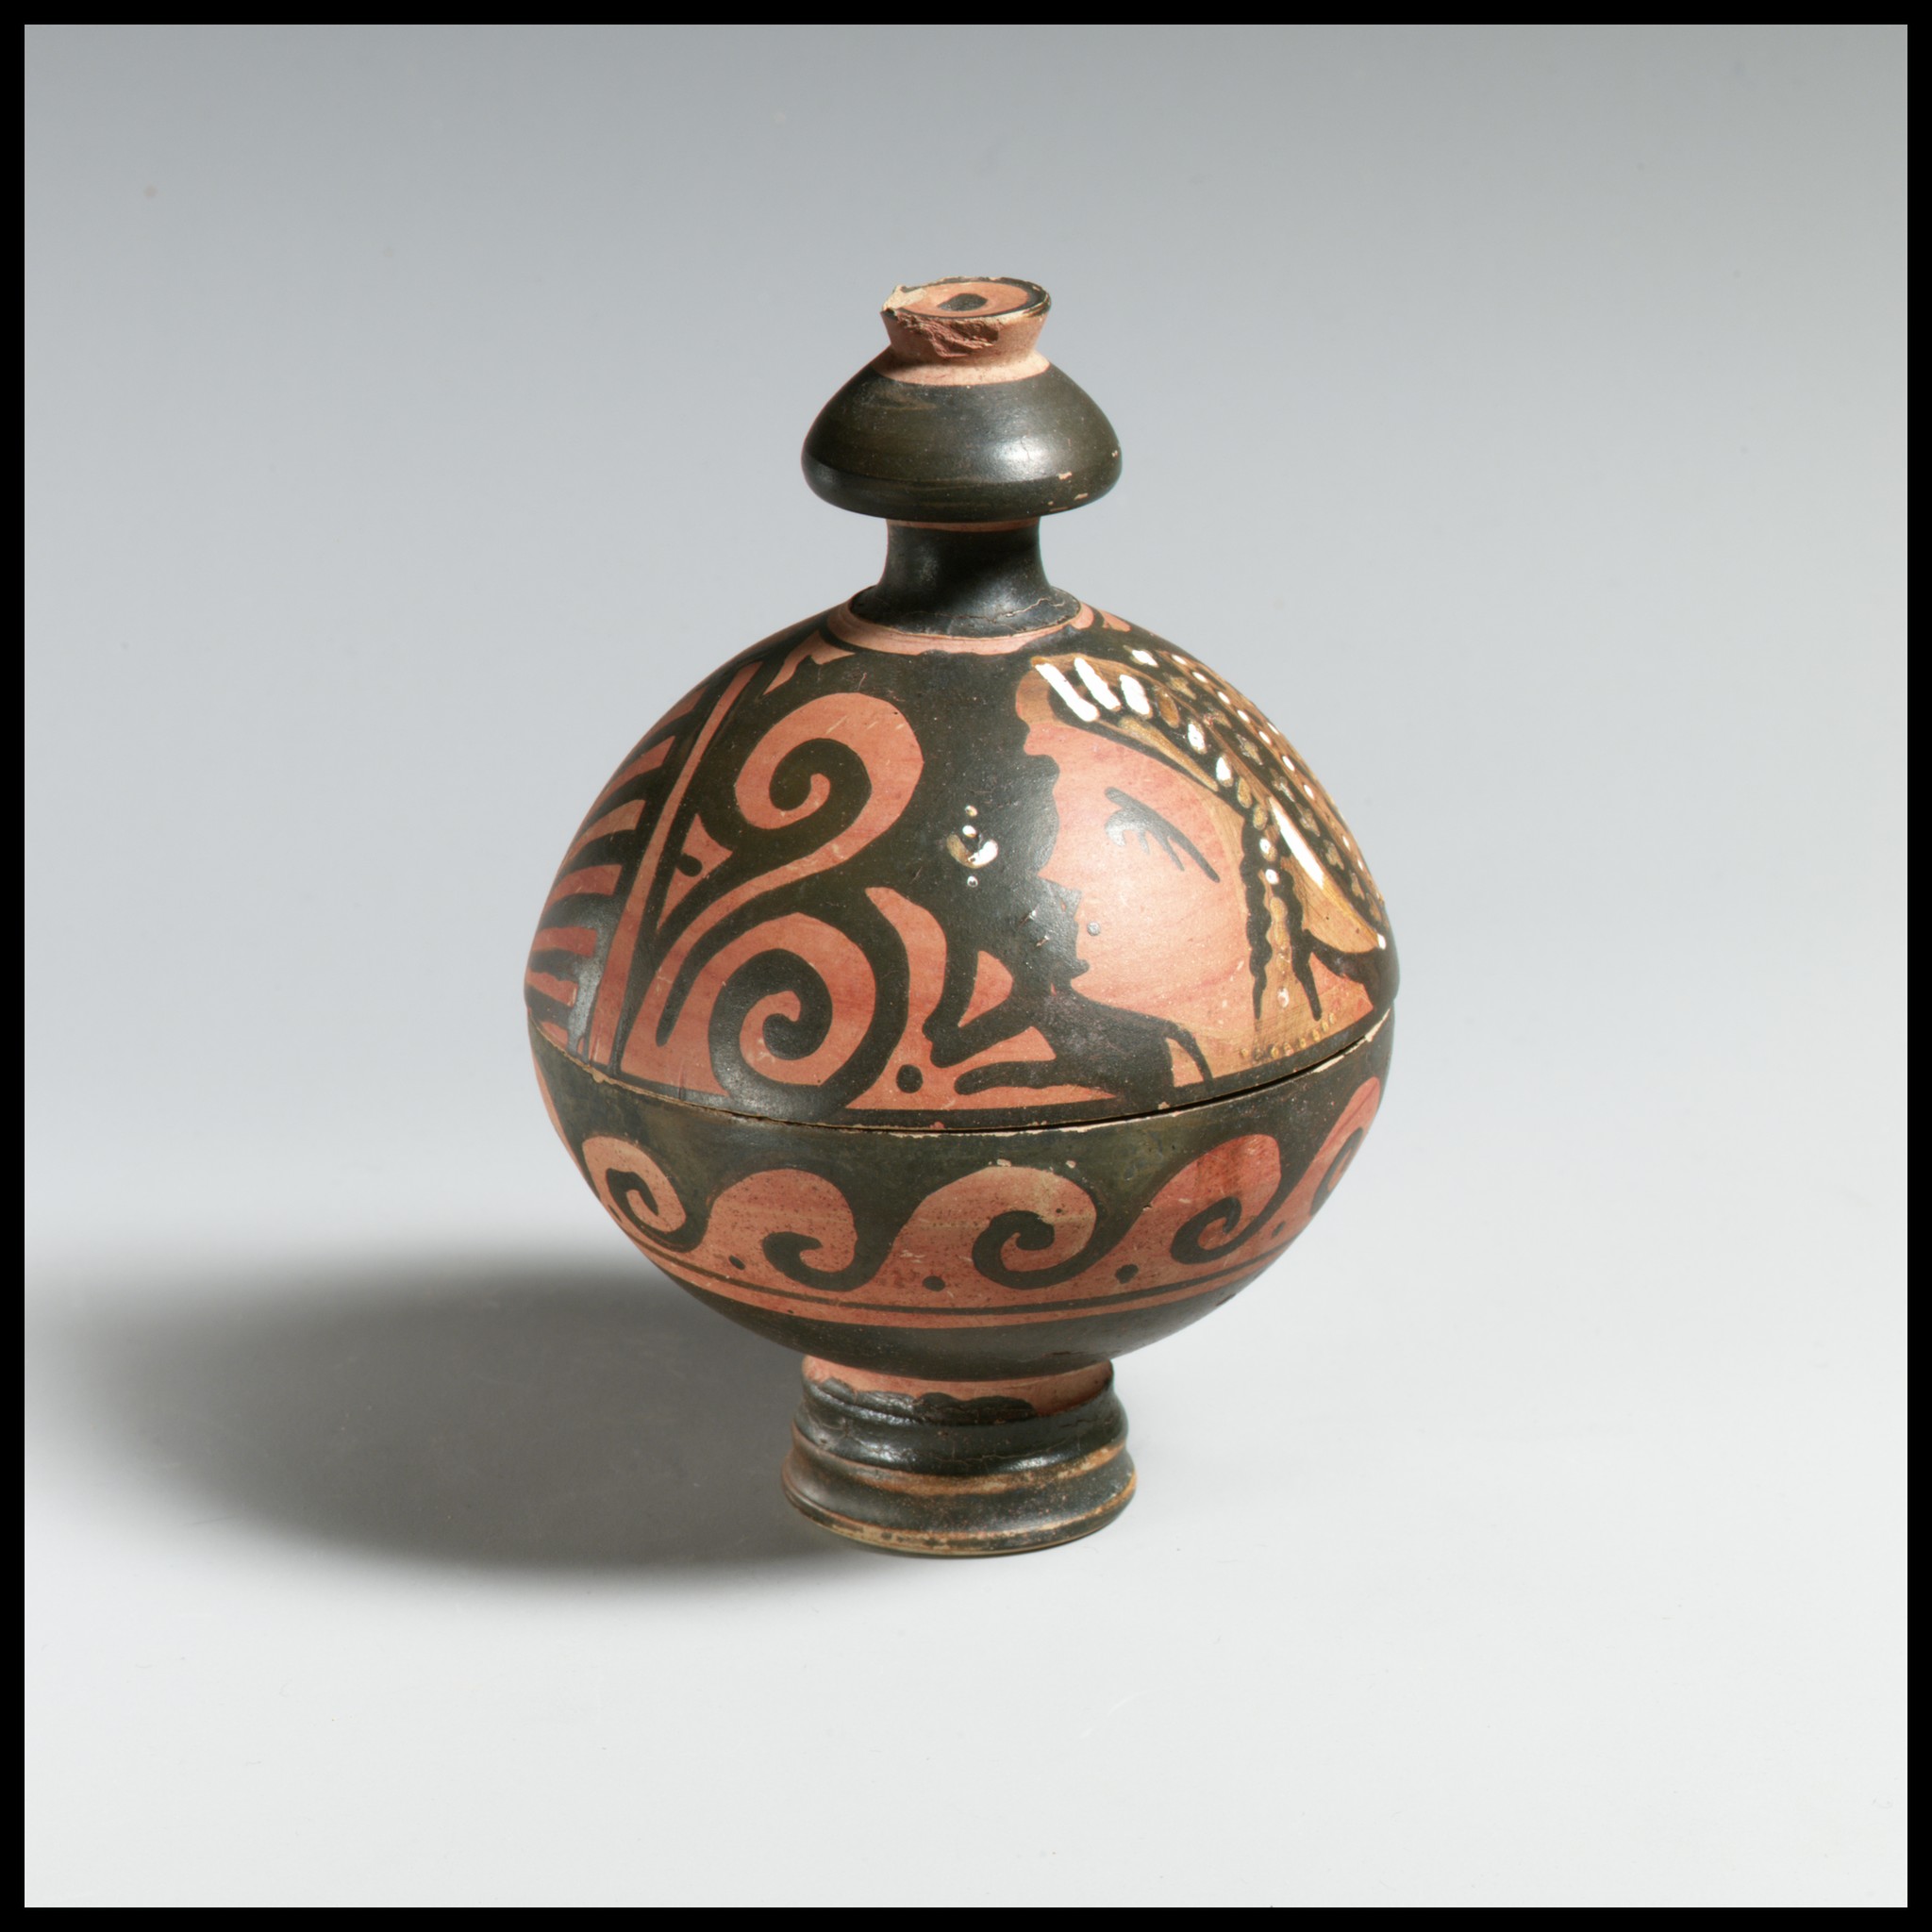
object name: pyxis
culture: greek, south italian, apulian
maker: kantharos group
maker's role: artist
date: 325-300 BCE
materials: terracotta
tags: heads,profiles,women